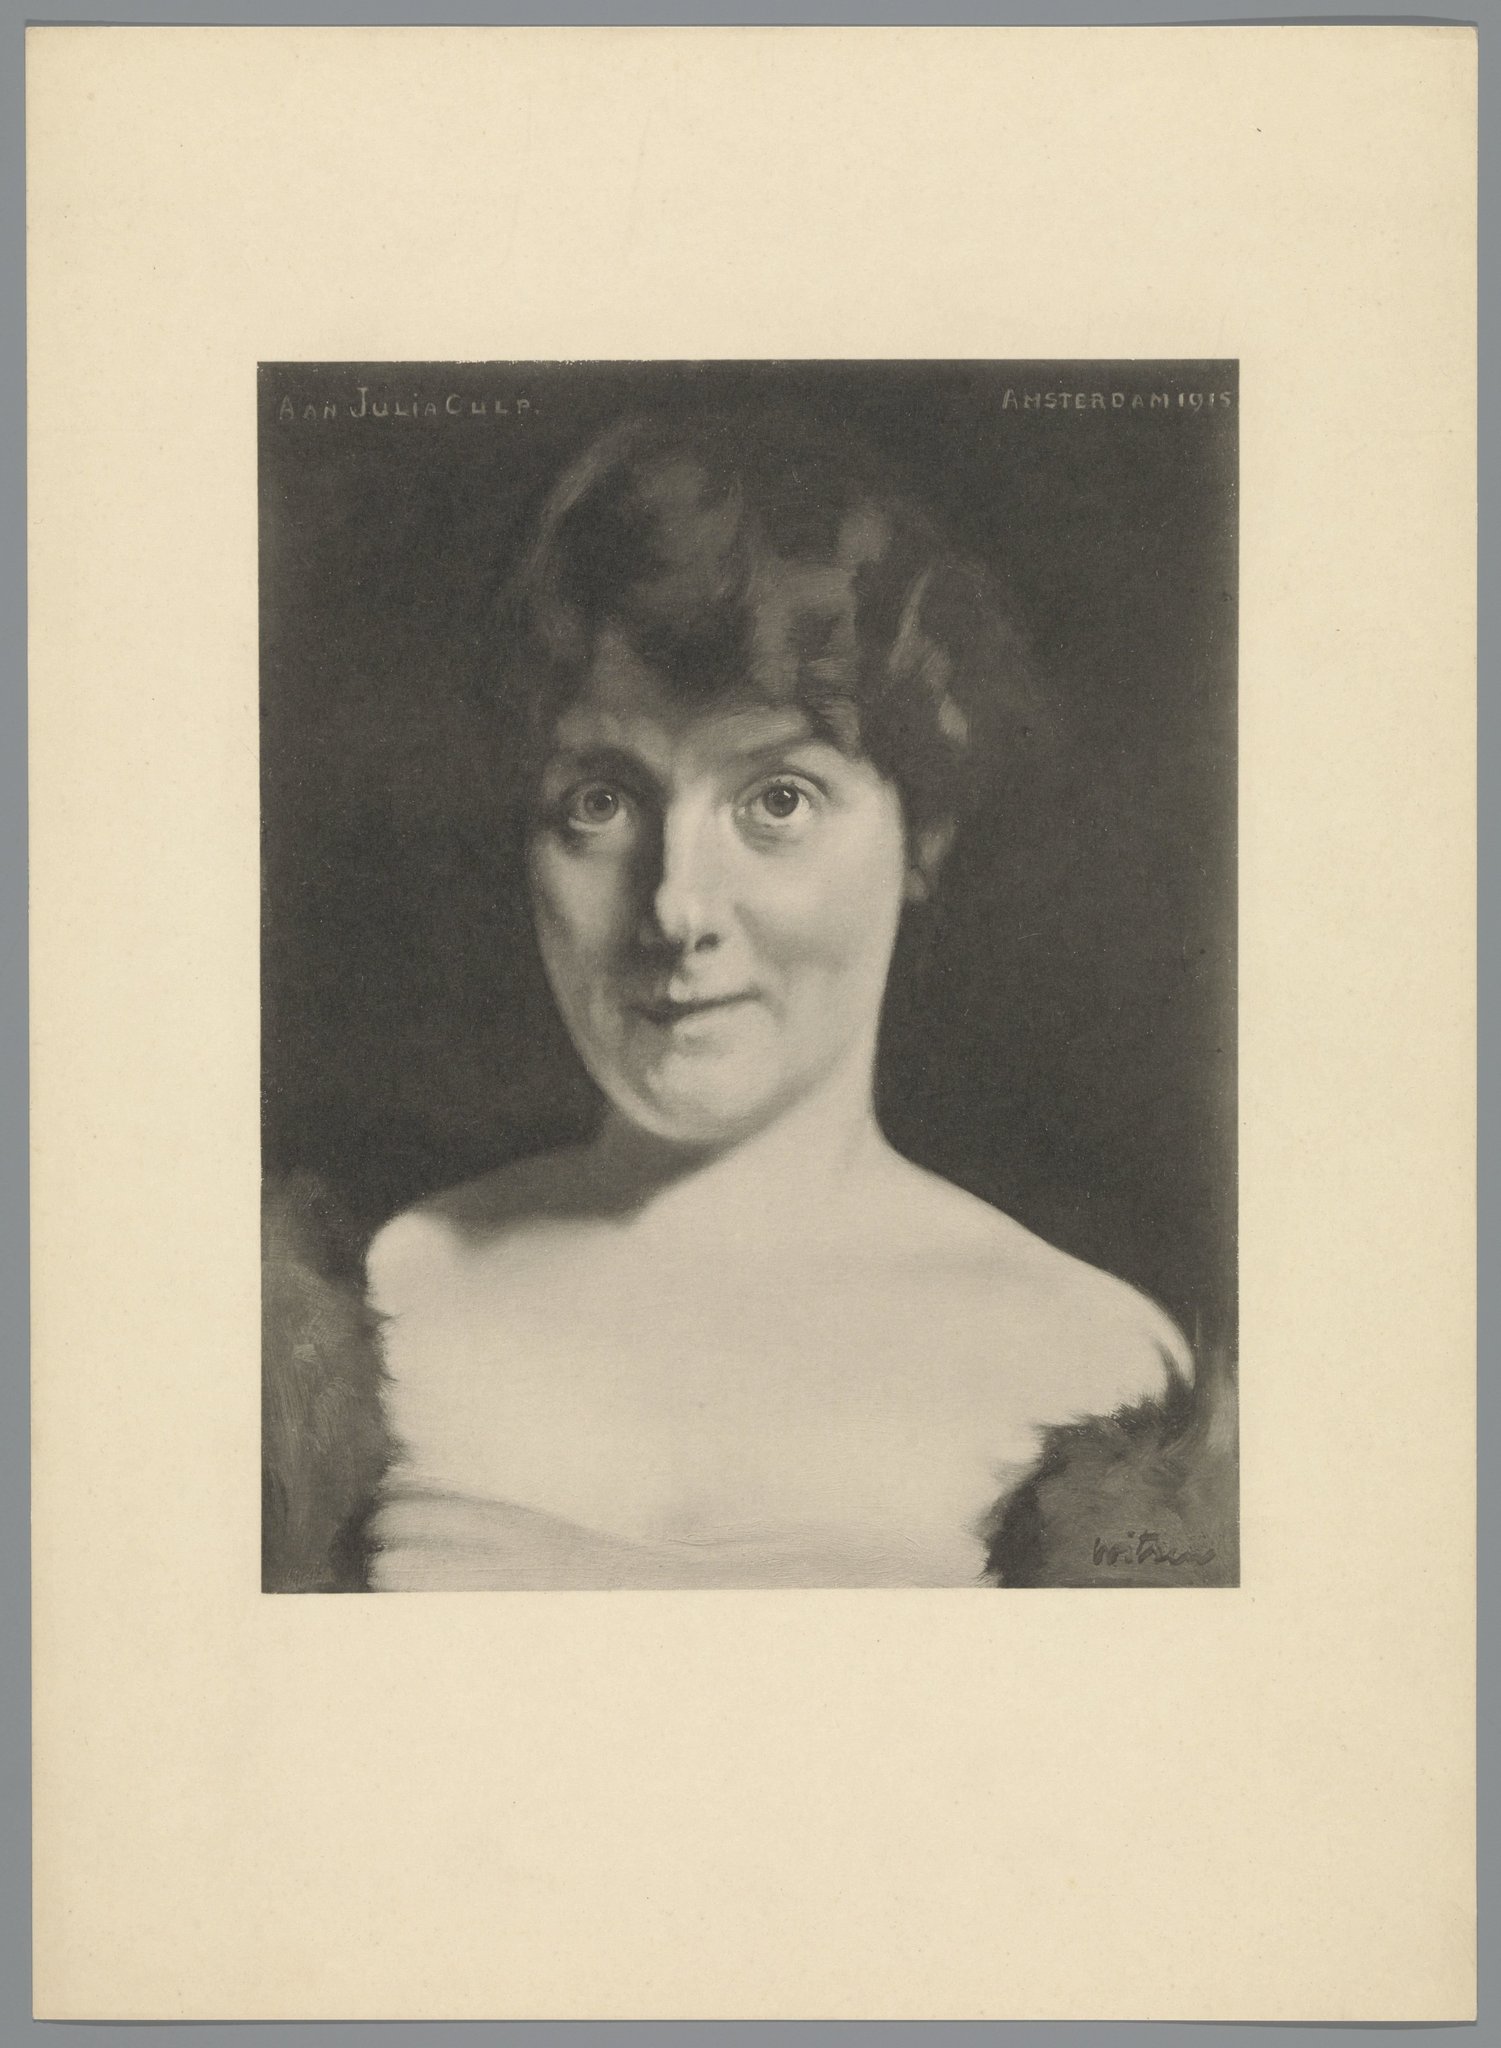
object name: print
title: Reproductie naar schilderij met portret van Julia Culp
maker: Anonymous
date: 1915-1925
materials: paper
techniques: photograph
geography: netherlands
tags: amsterdam